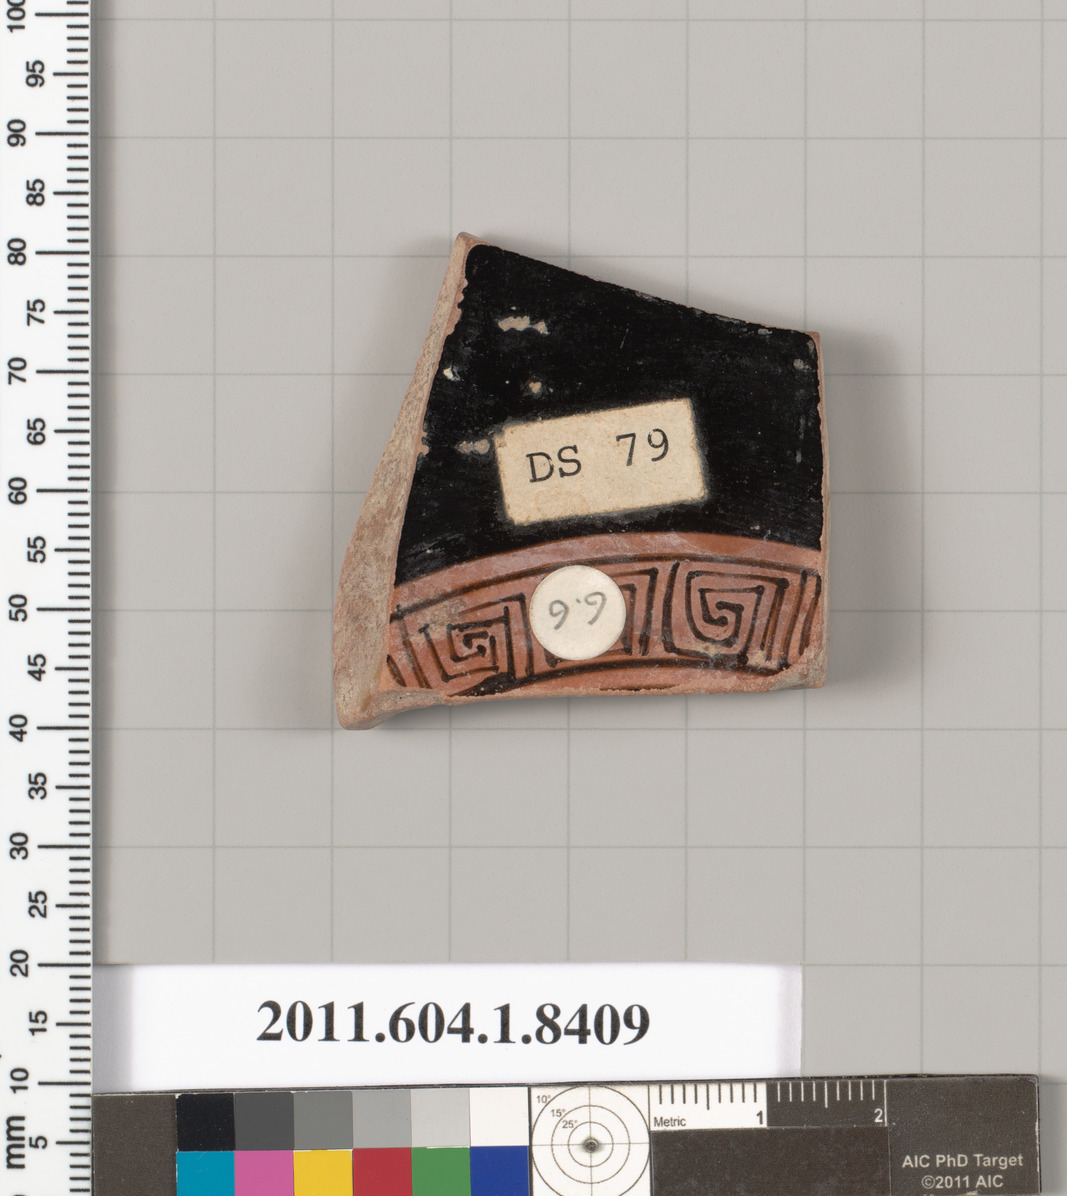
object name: kylix fragment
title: Terracotta fragment of a kylix (drinking cup)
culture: greek, attic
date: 434-368 BCE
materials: terracotta